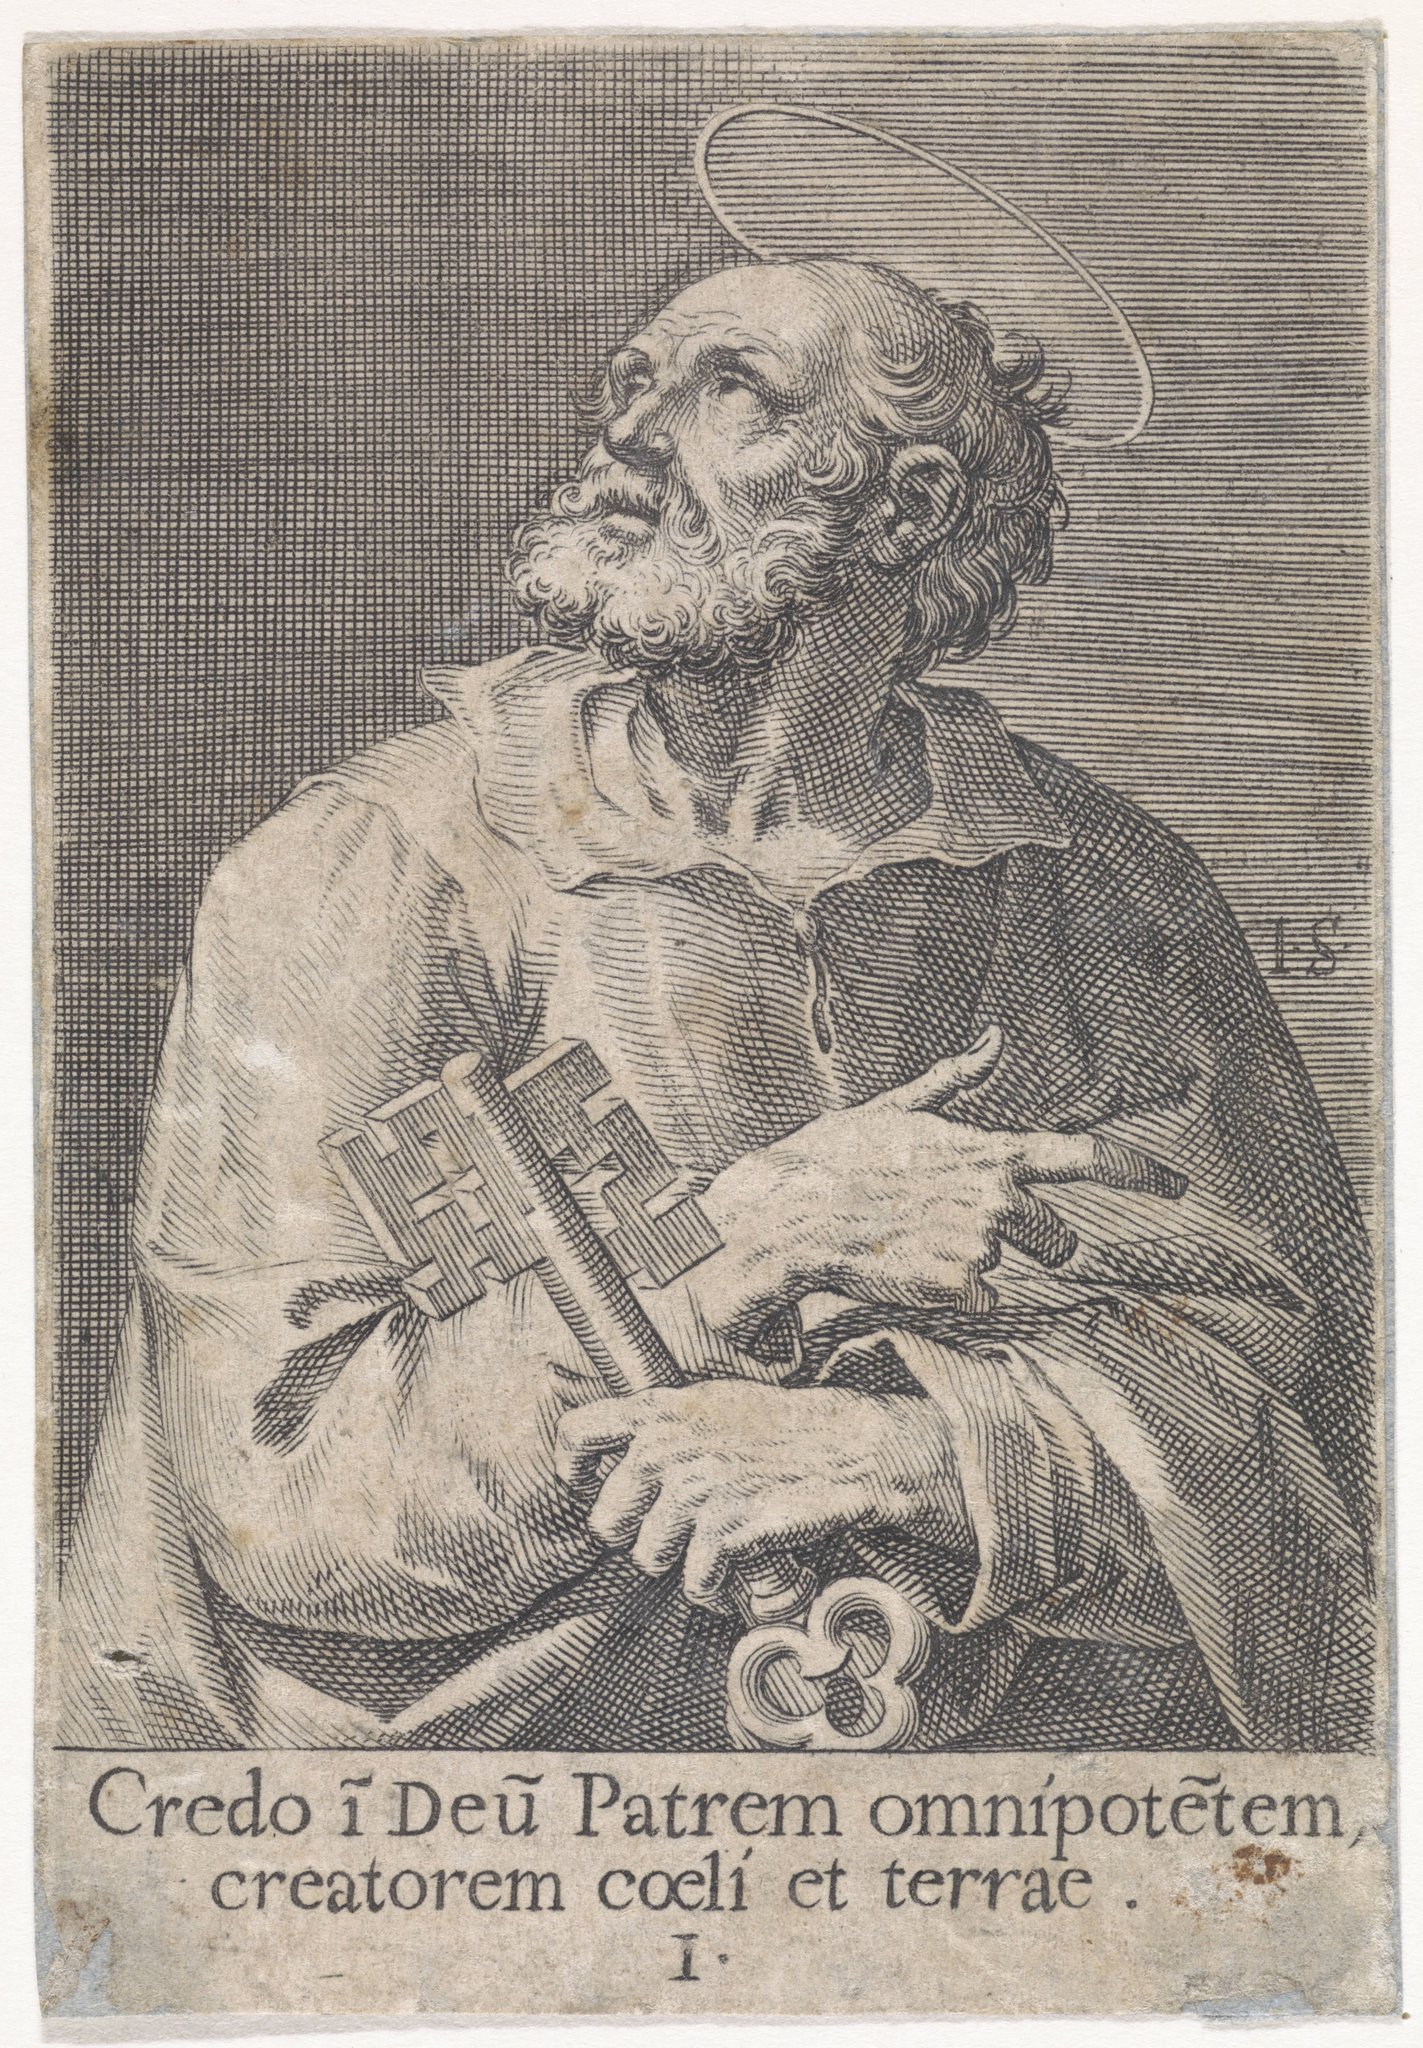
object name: print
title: Apostel Petrus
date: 1570-1600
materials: paper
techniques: engraving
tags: the apostle peter, first bishop of rome; possible attributes: book, cock, (upturned) cross, (triple) crozier, fish, key, scroll, ship, tiara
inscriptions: collector's mark: Lugt 240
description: De apostel Petrus, met als attribuut de sleutel van de het koninkrijk der hemelen. De prent heeft een Latijns onderschrijft met een regel uit het Credo. De derde prent in een serie van veertien waarvan de prenten met een apostel genummerd zijn van 1 tot 12.